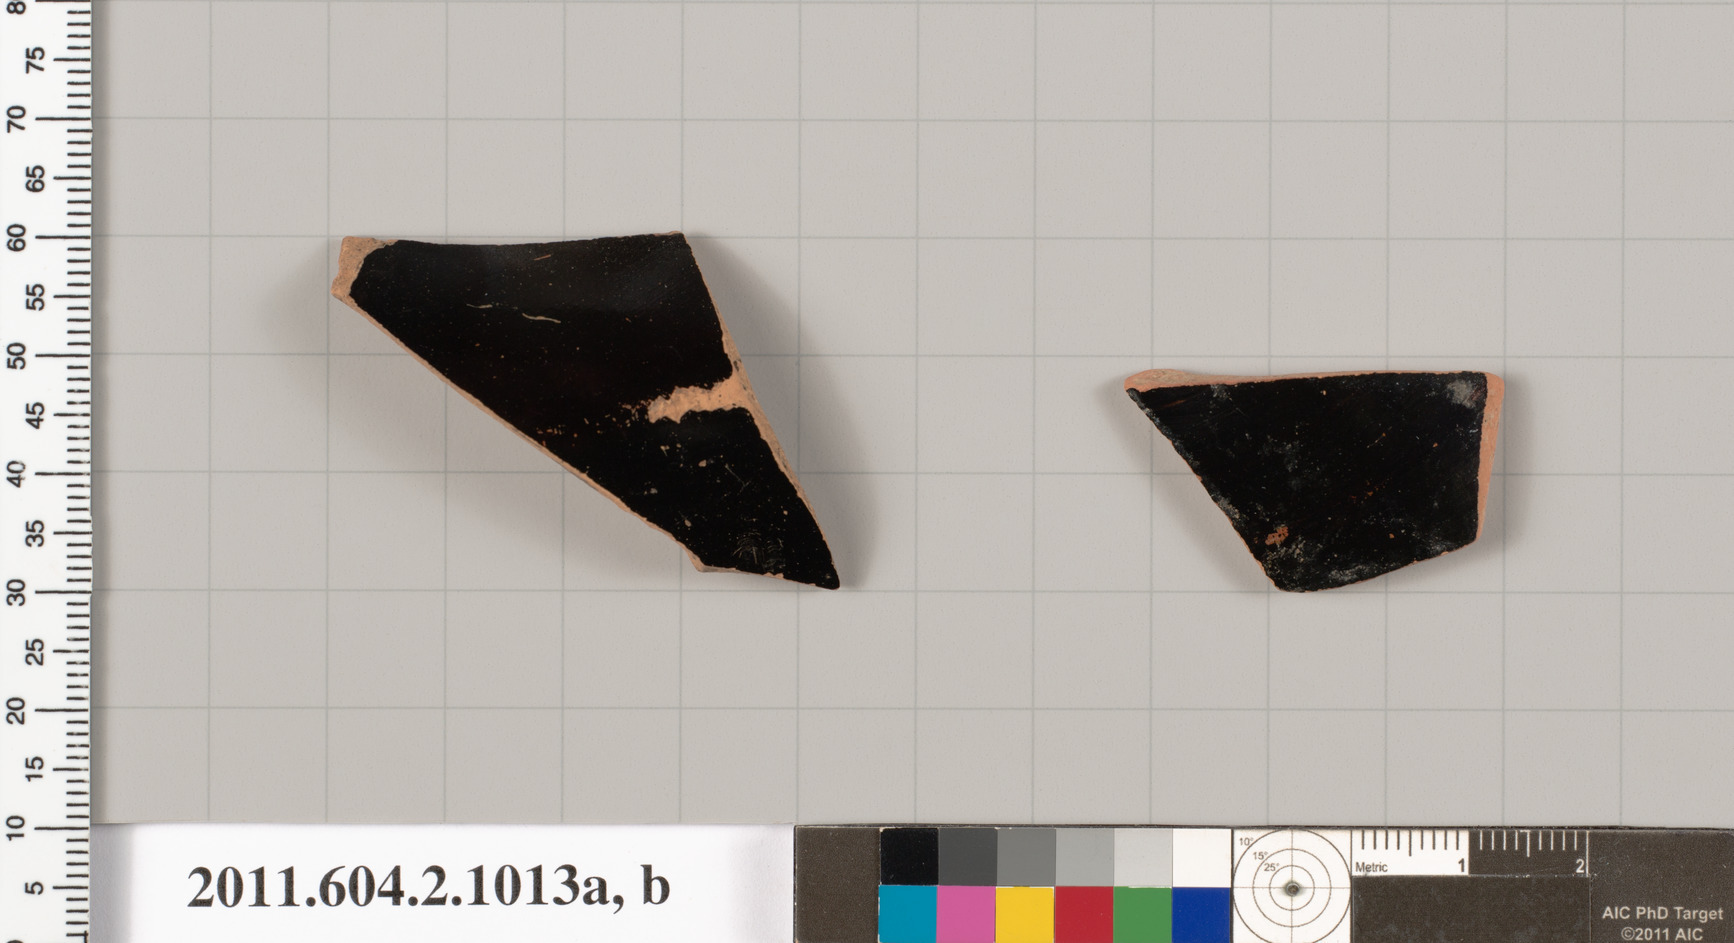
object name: oinochoe fragment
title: Terracotta fragments of oinochoai (jugs)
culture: greek, attic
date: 475-425 BCE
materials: terracotta